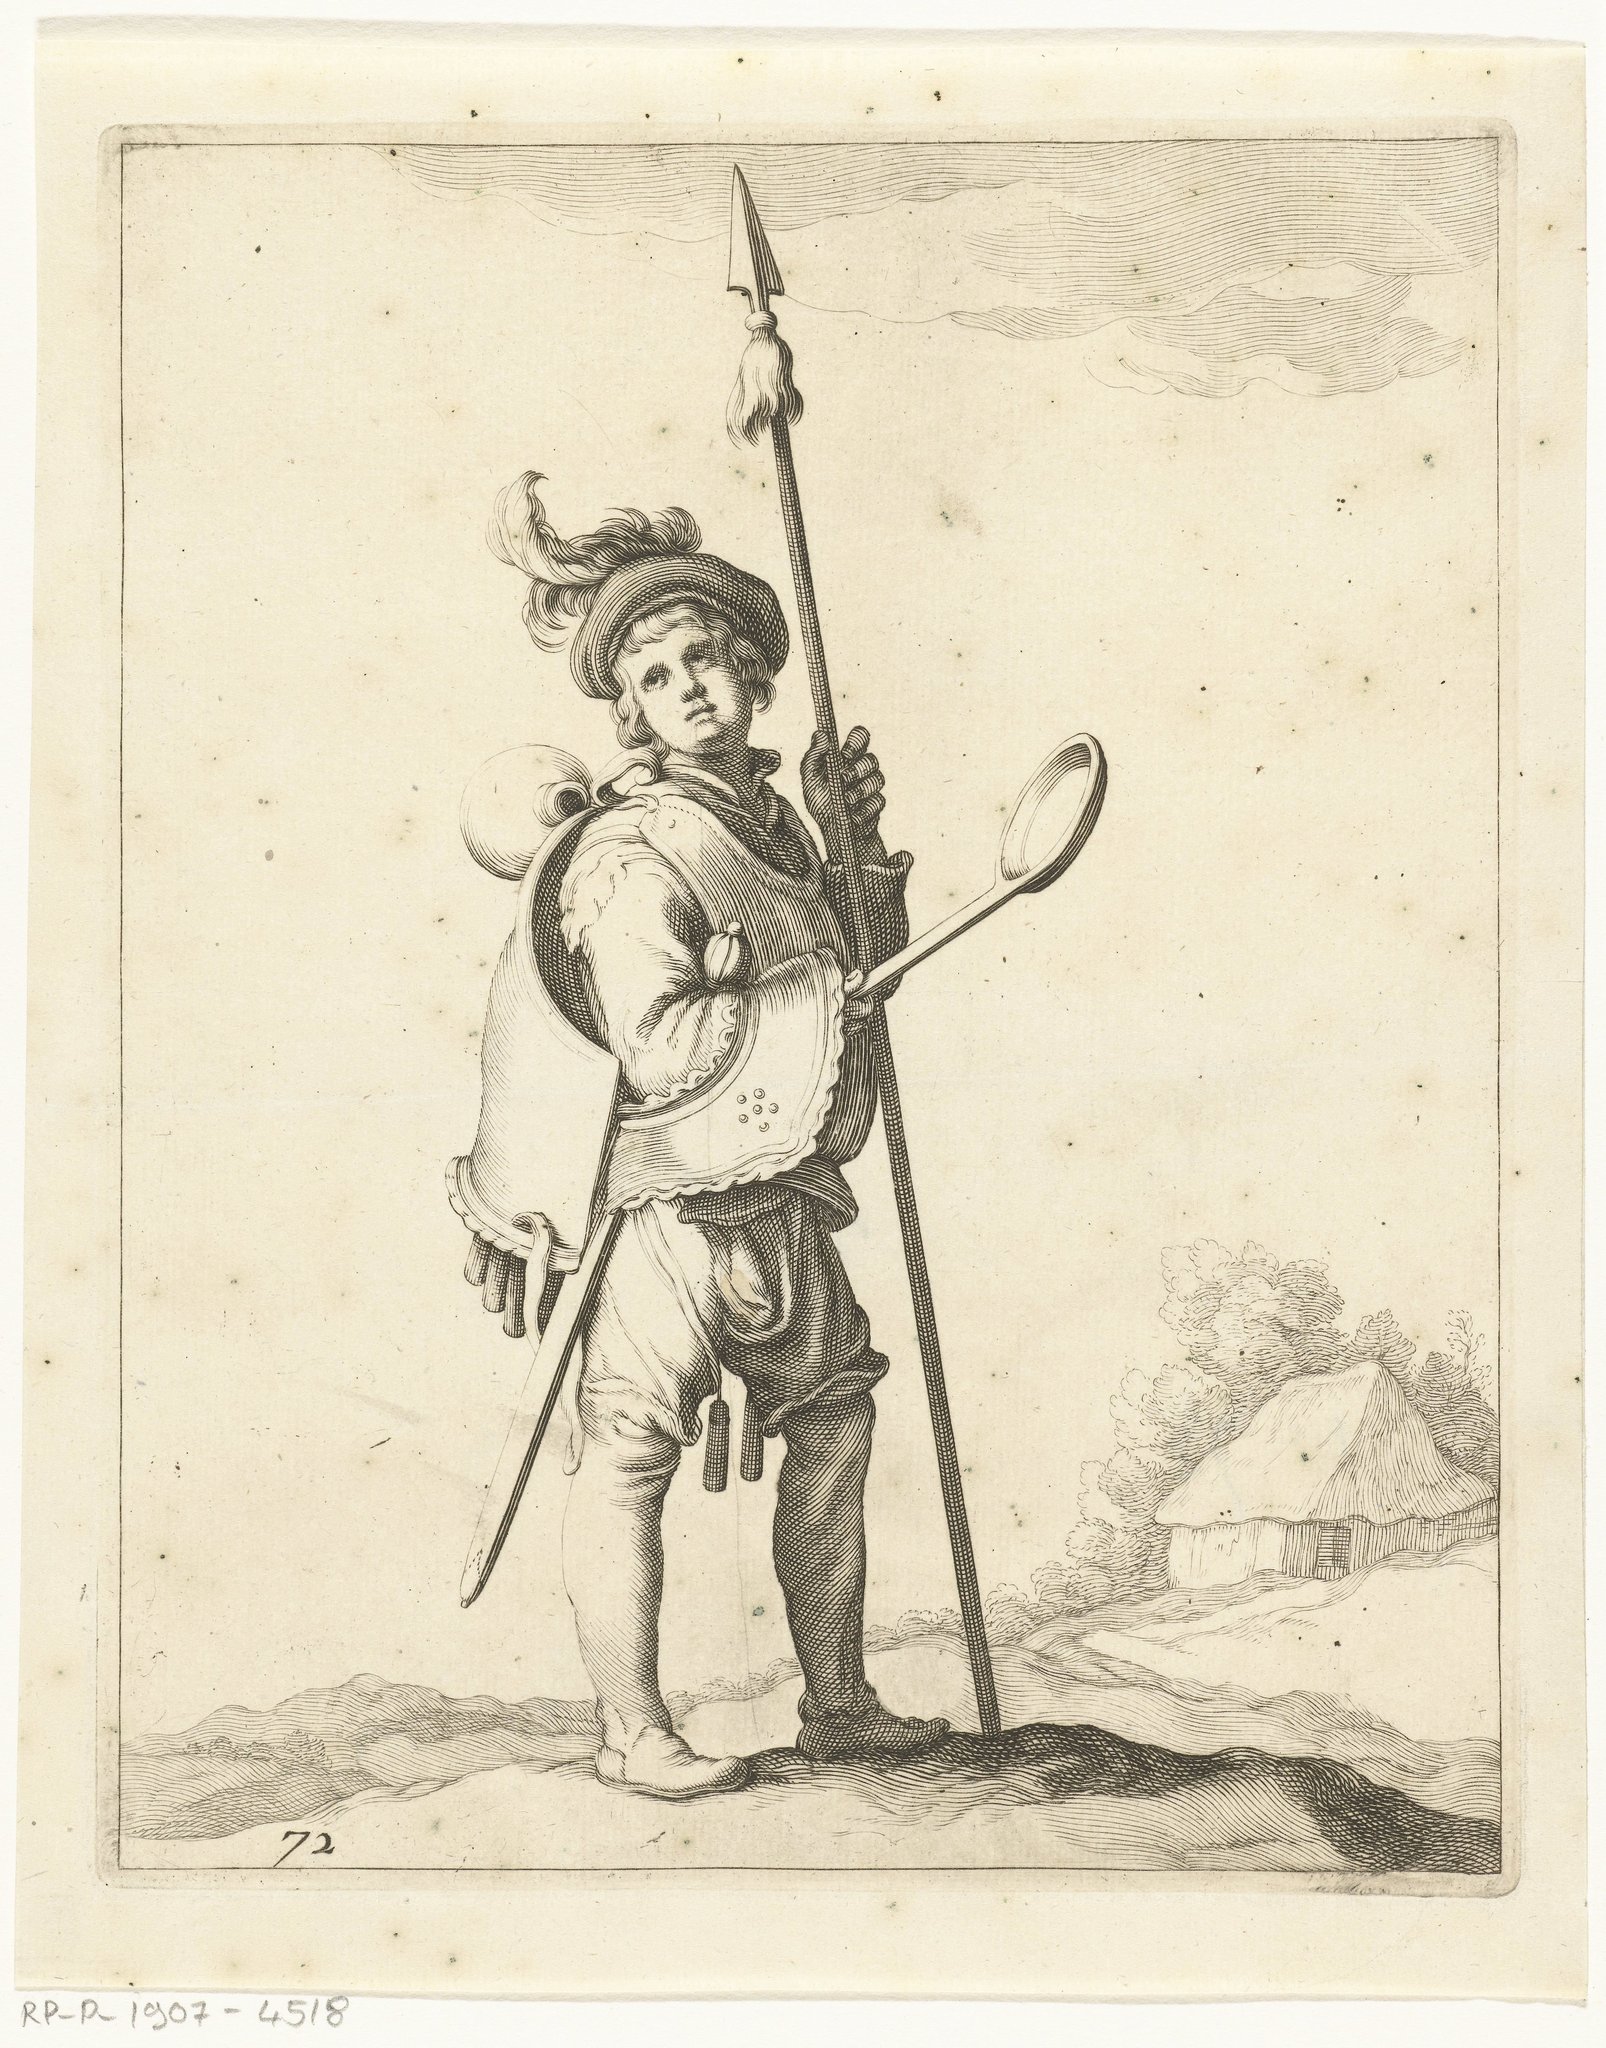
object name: print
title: Soldatenjongen met speer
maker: frederick bloemaert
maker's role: print maker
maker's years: 1614-1669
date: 1650-1700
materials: paper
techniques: engraving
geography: utrecht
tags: the soldier; the soldier's life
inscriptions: collector's mark: Lugt 2228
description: Een jonge soldaat met pluim op de hoed en speer in de hand. In de andere hand houdt hij een pan.